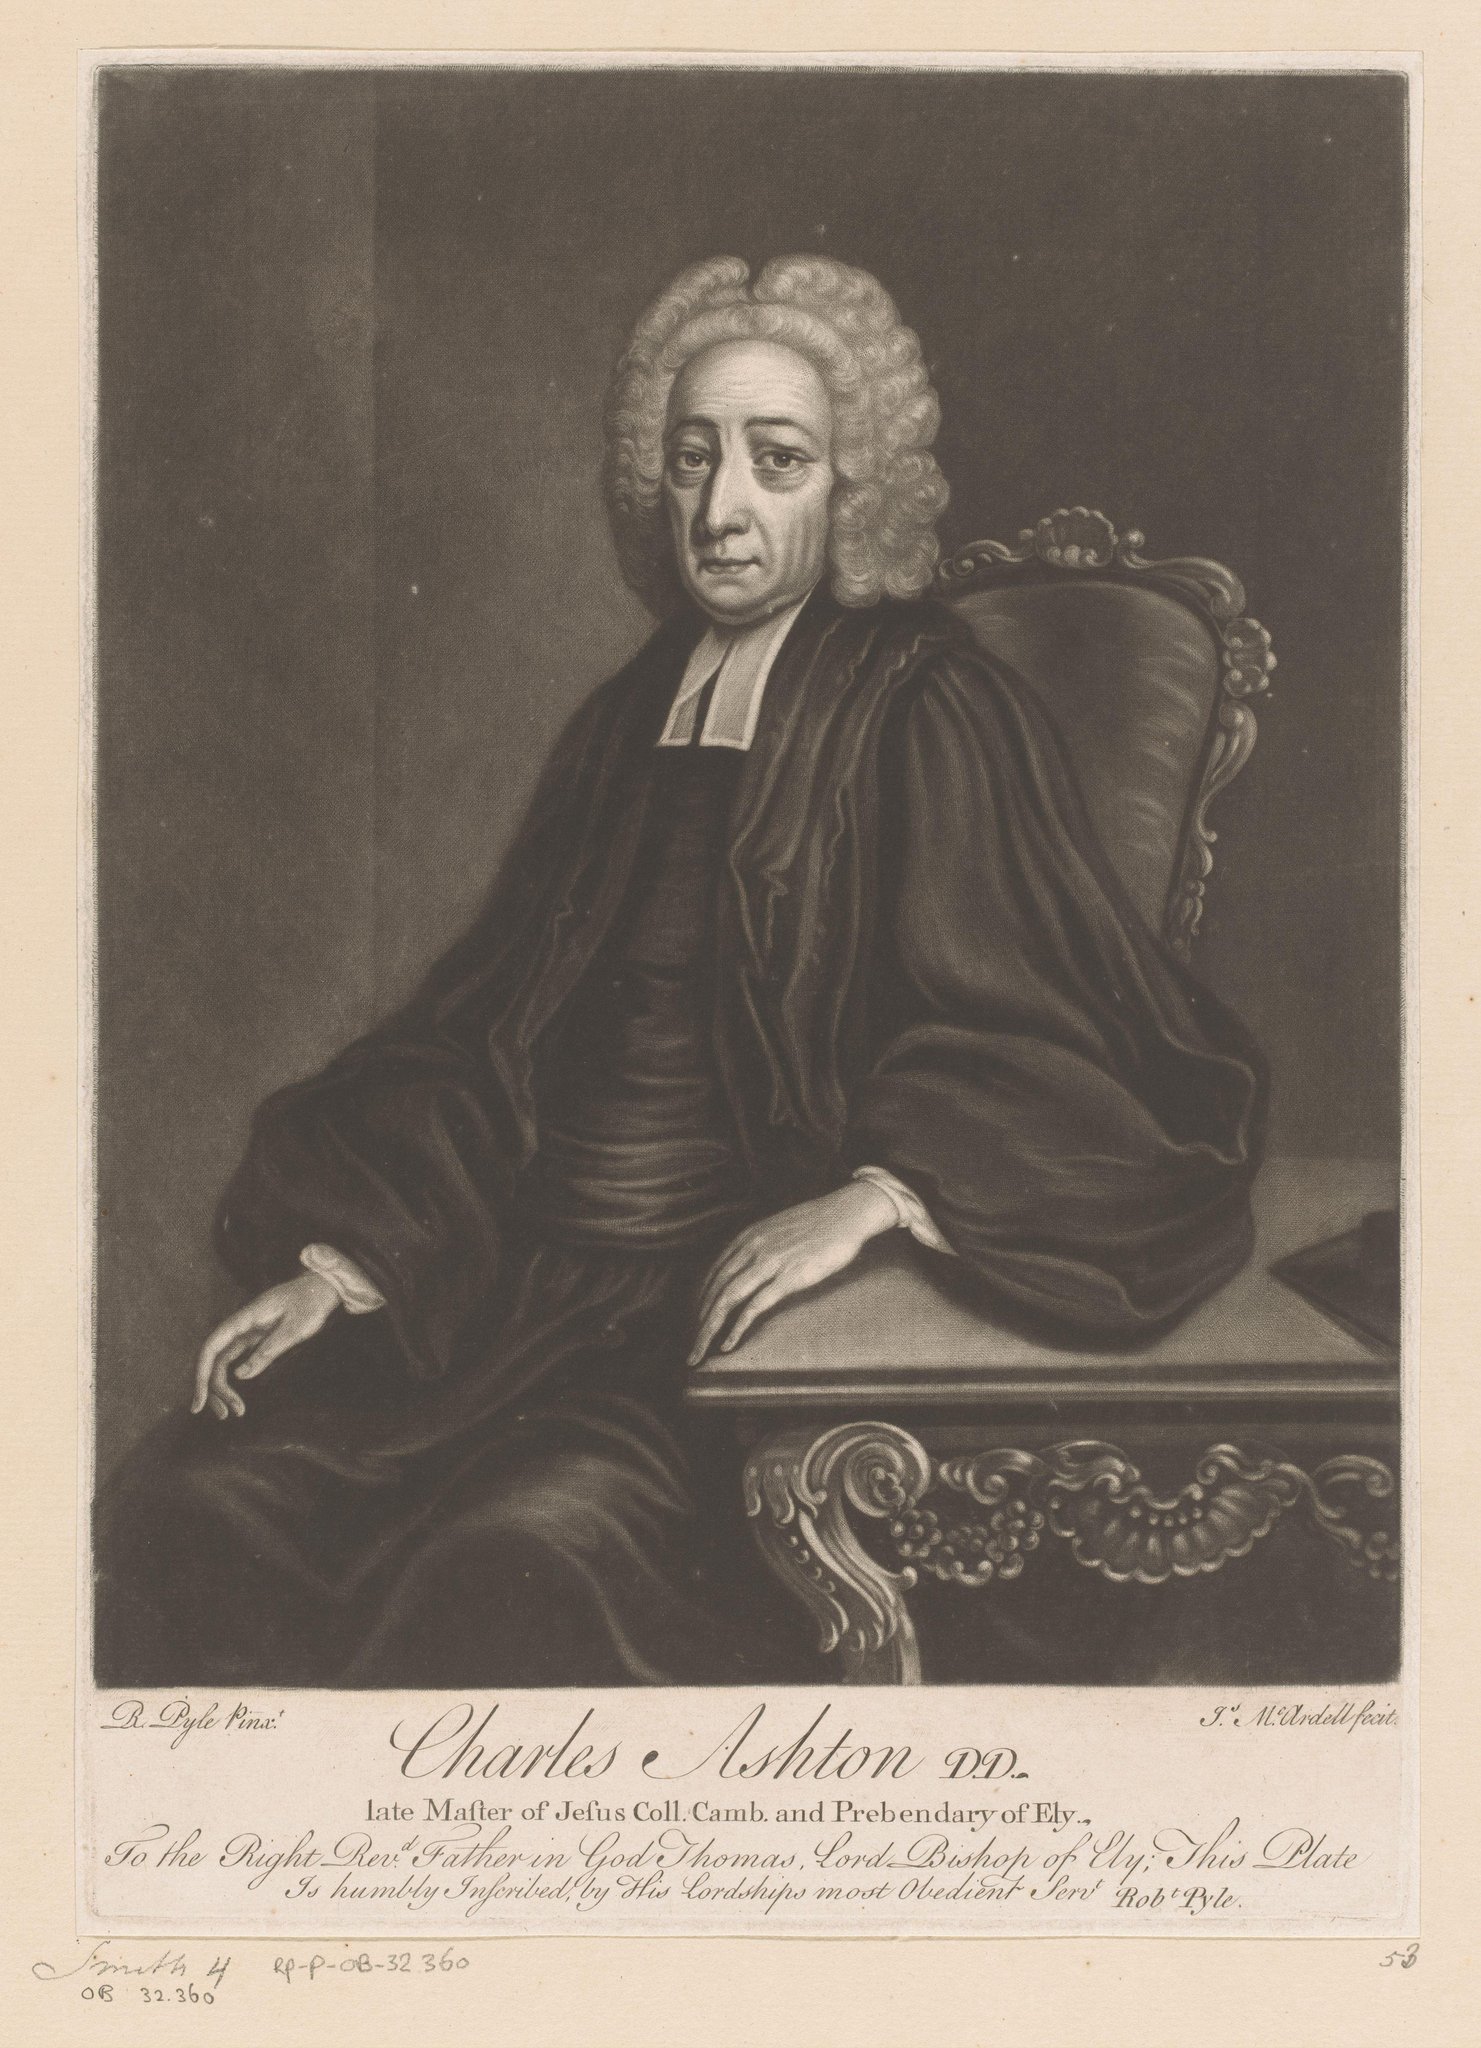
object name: print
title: Portret van Charles Ashton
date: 1752-1754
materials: paper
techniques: mezzotint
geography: london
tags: clergyman, historical persons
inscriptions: collector's mark: Lugt 240